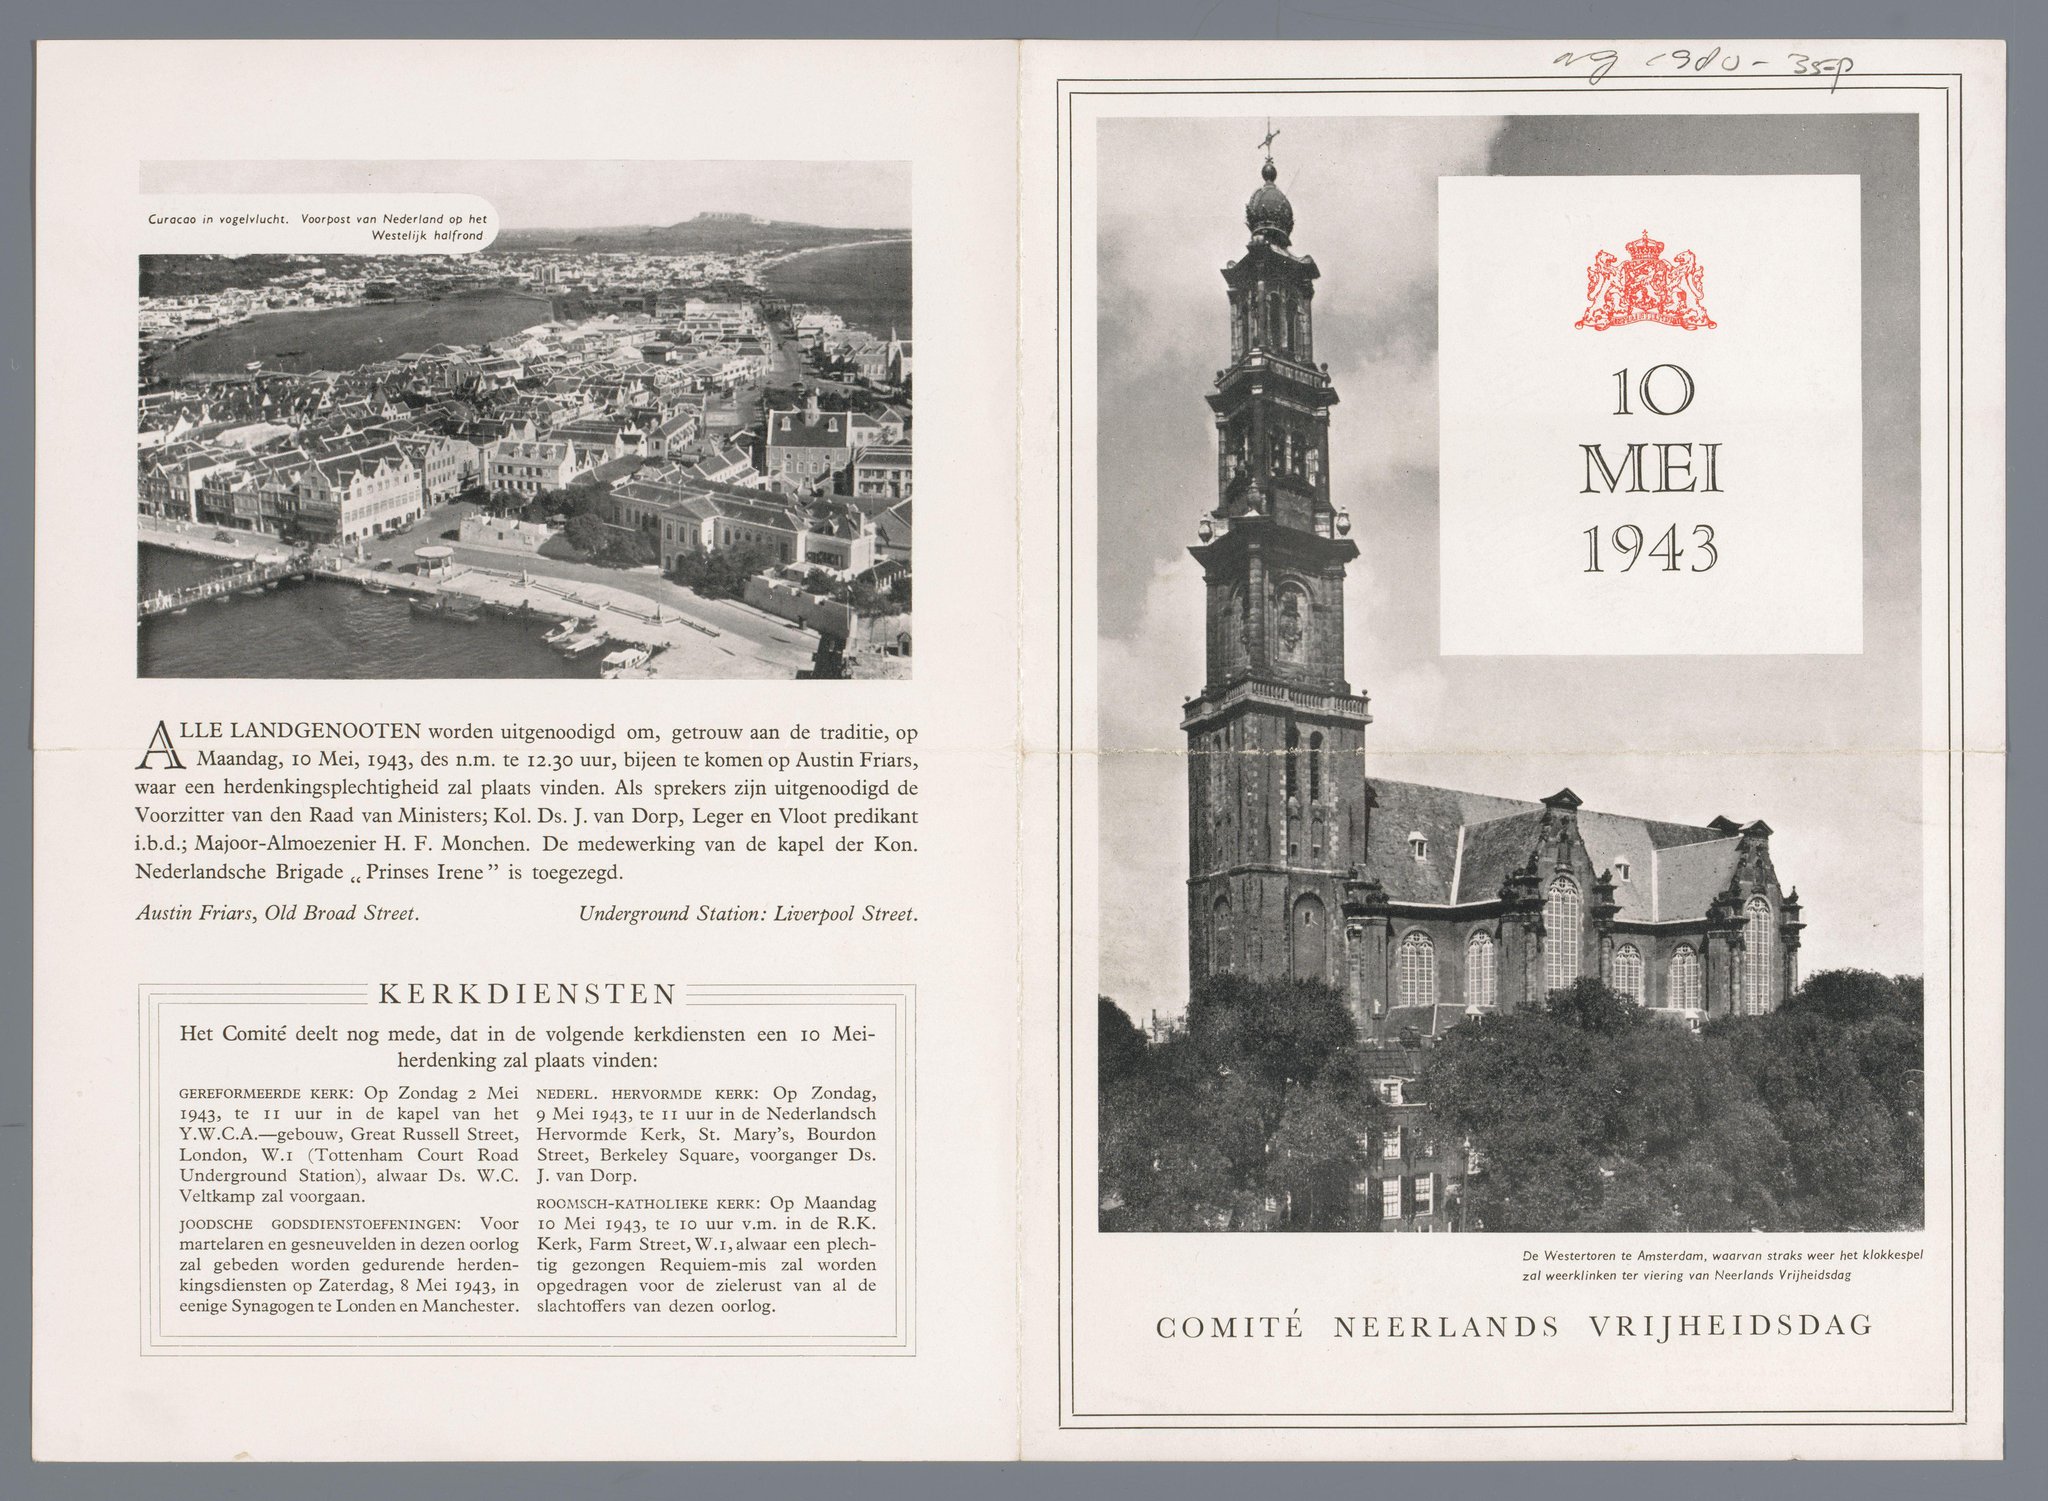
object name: leaflet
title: 10 mei 1943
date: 1943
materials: paper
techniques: printing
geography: london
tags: london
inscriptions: date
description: Vouwblad, voor een herdenking van 10 mei 1940 op het terrein van de gebombardeerde kerk Austin Friars in Londen met daarin een los vel met te zingen liederen. Gedateerd; voorp.: 10 mei 1943.